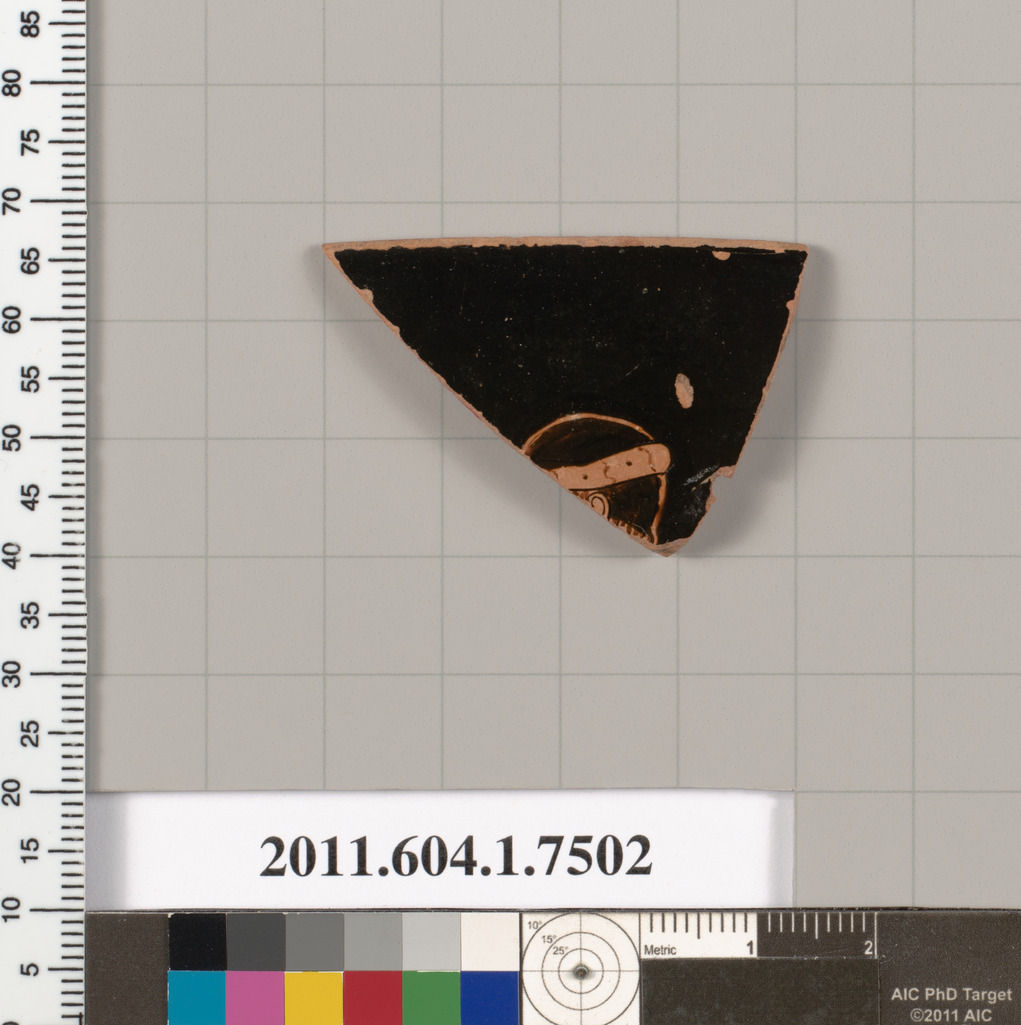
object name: kylix fragment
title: Terracotta rim fragment of a kylix (drinking cup)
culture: greek, attic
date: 460-450 BCE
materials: terracotta